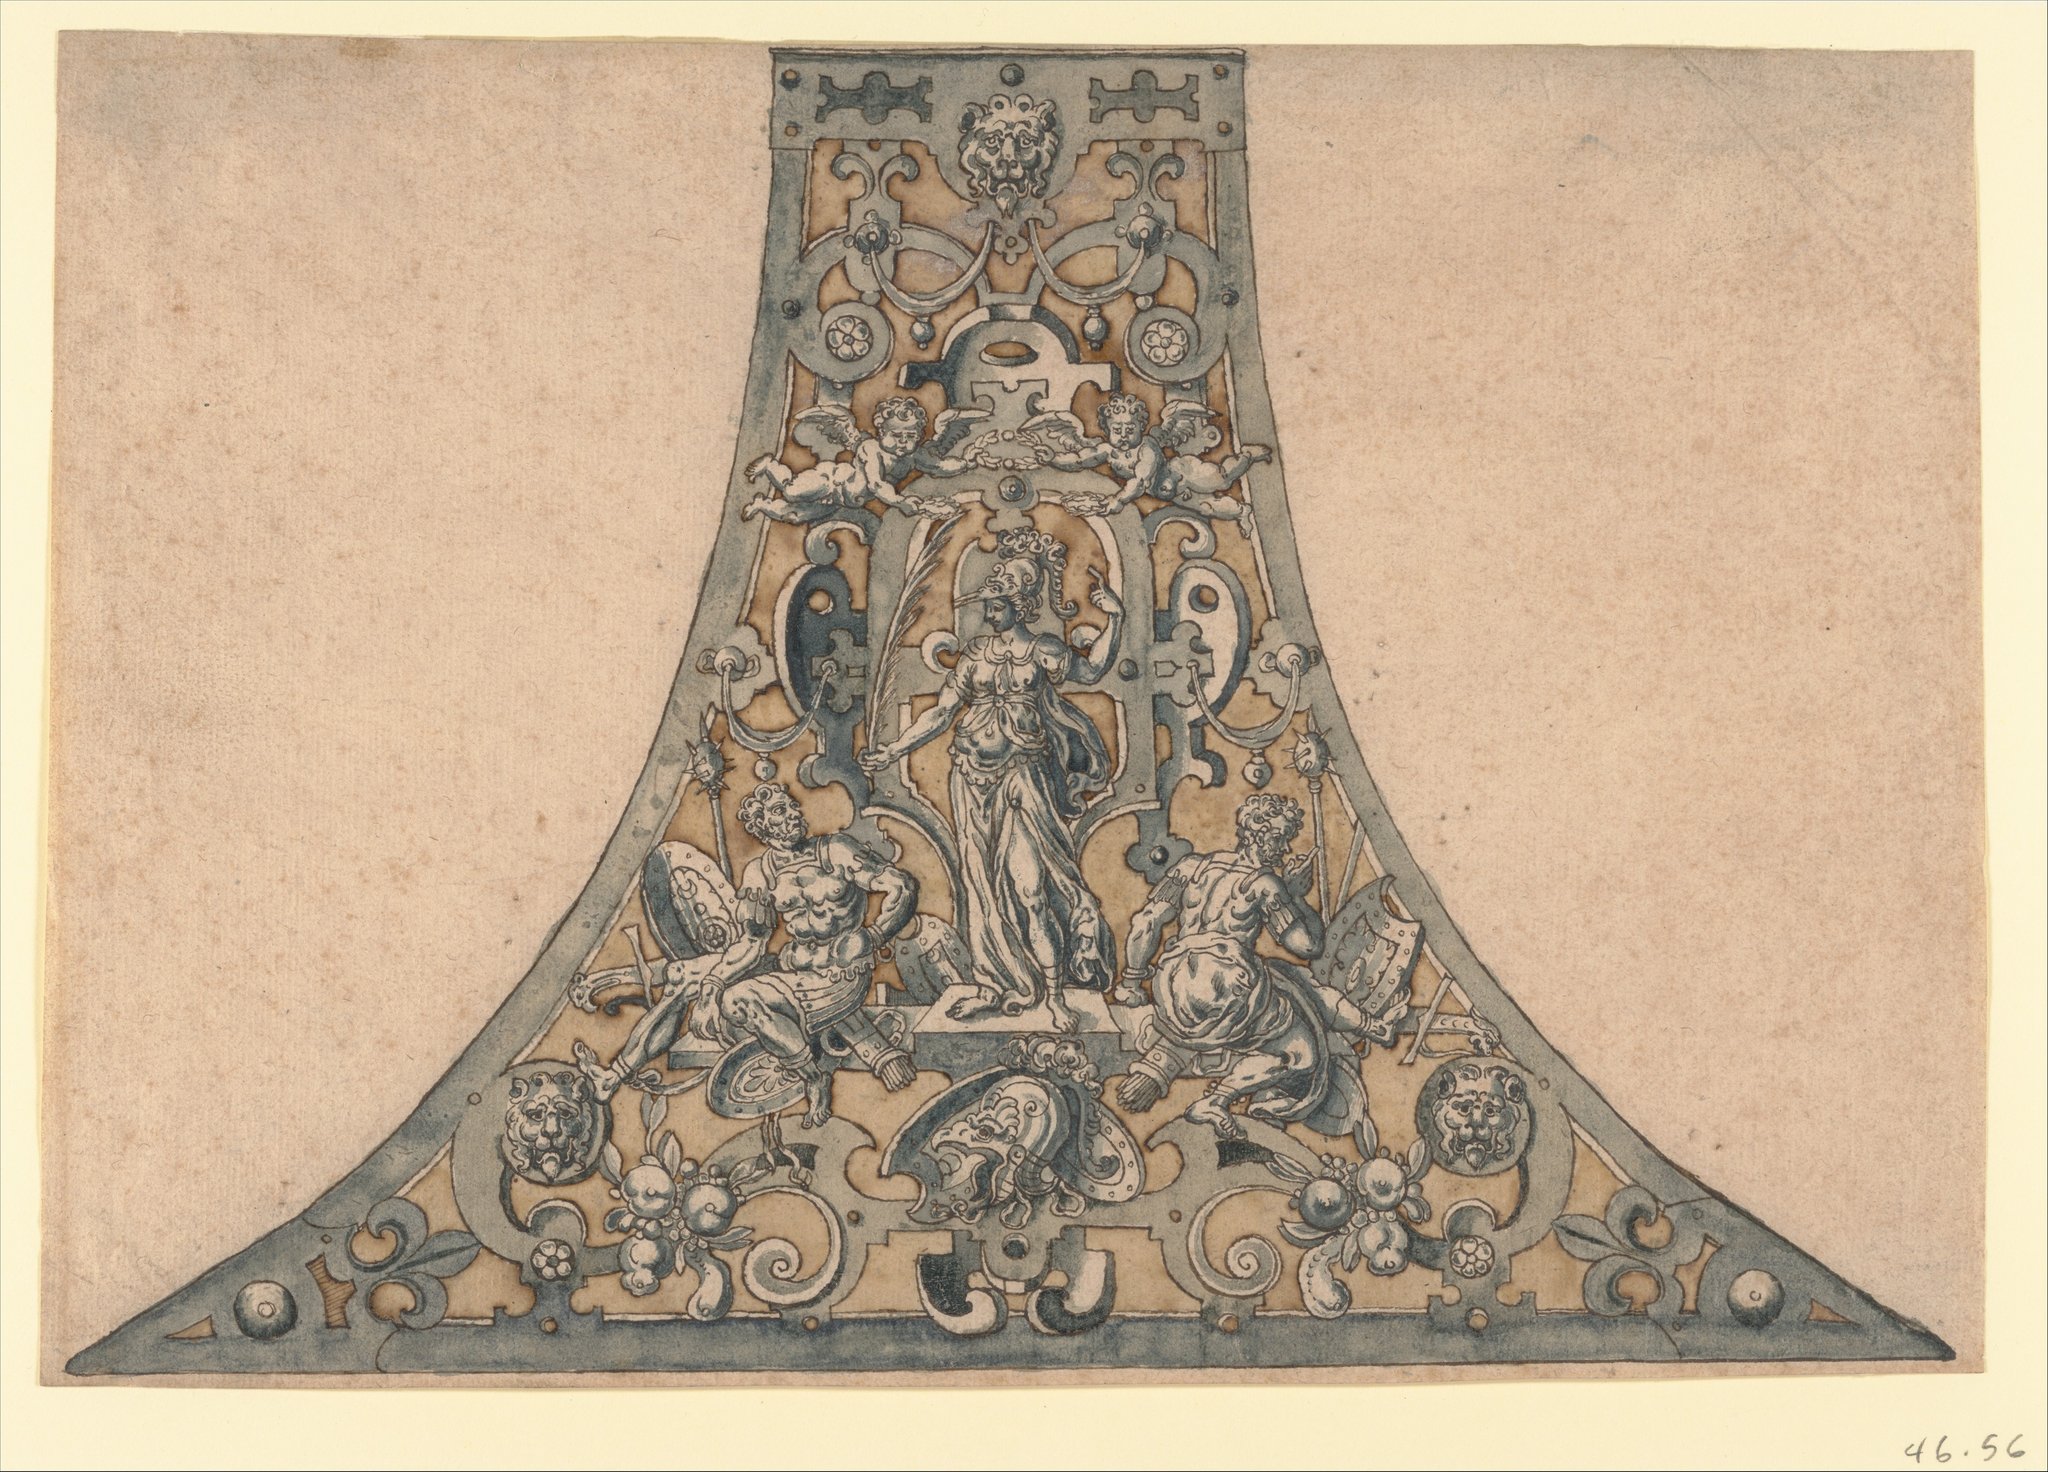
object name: collection ornament architecture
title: Design for a Powder Flask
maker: anonymous, german, 16th century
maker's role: artist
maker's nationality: german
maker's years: 1500-1600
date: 1540-1590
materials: ink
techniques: pen, wash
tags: soldiers,athena,angels